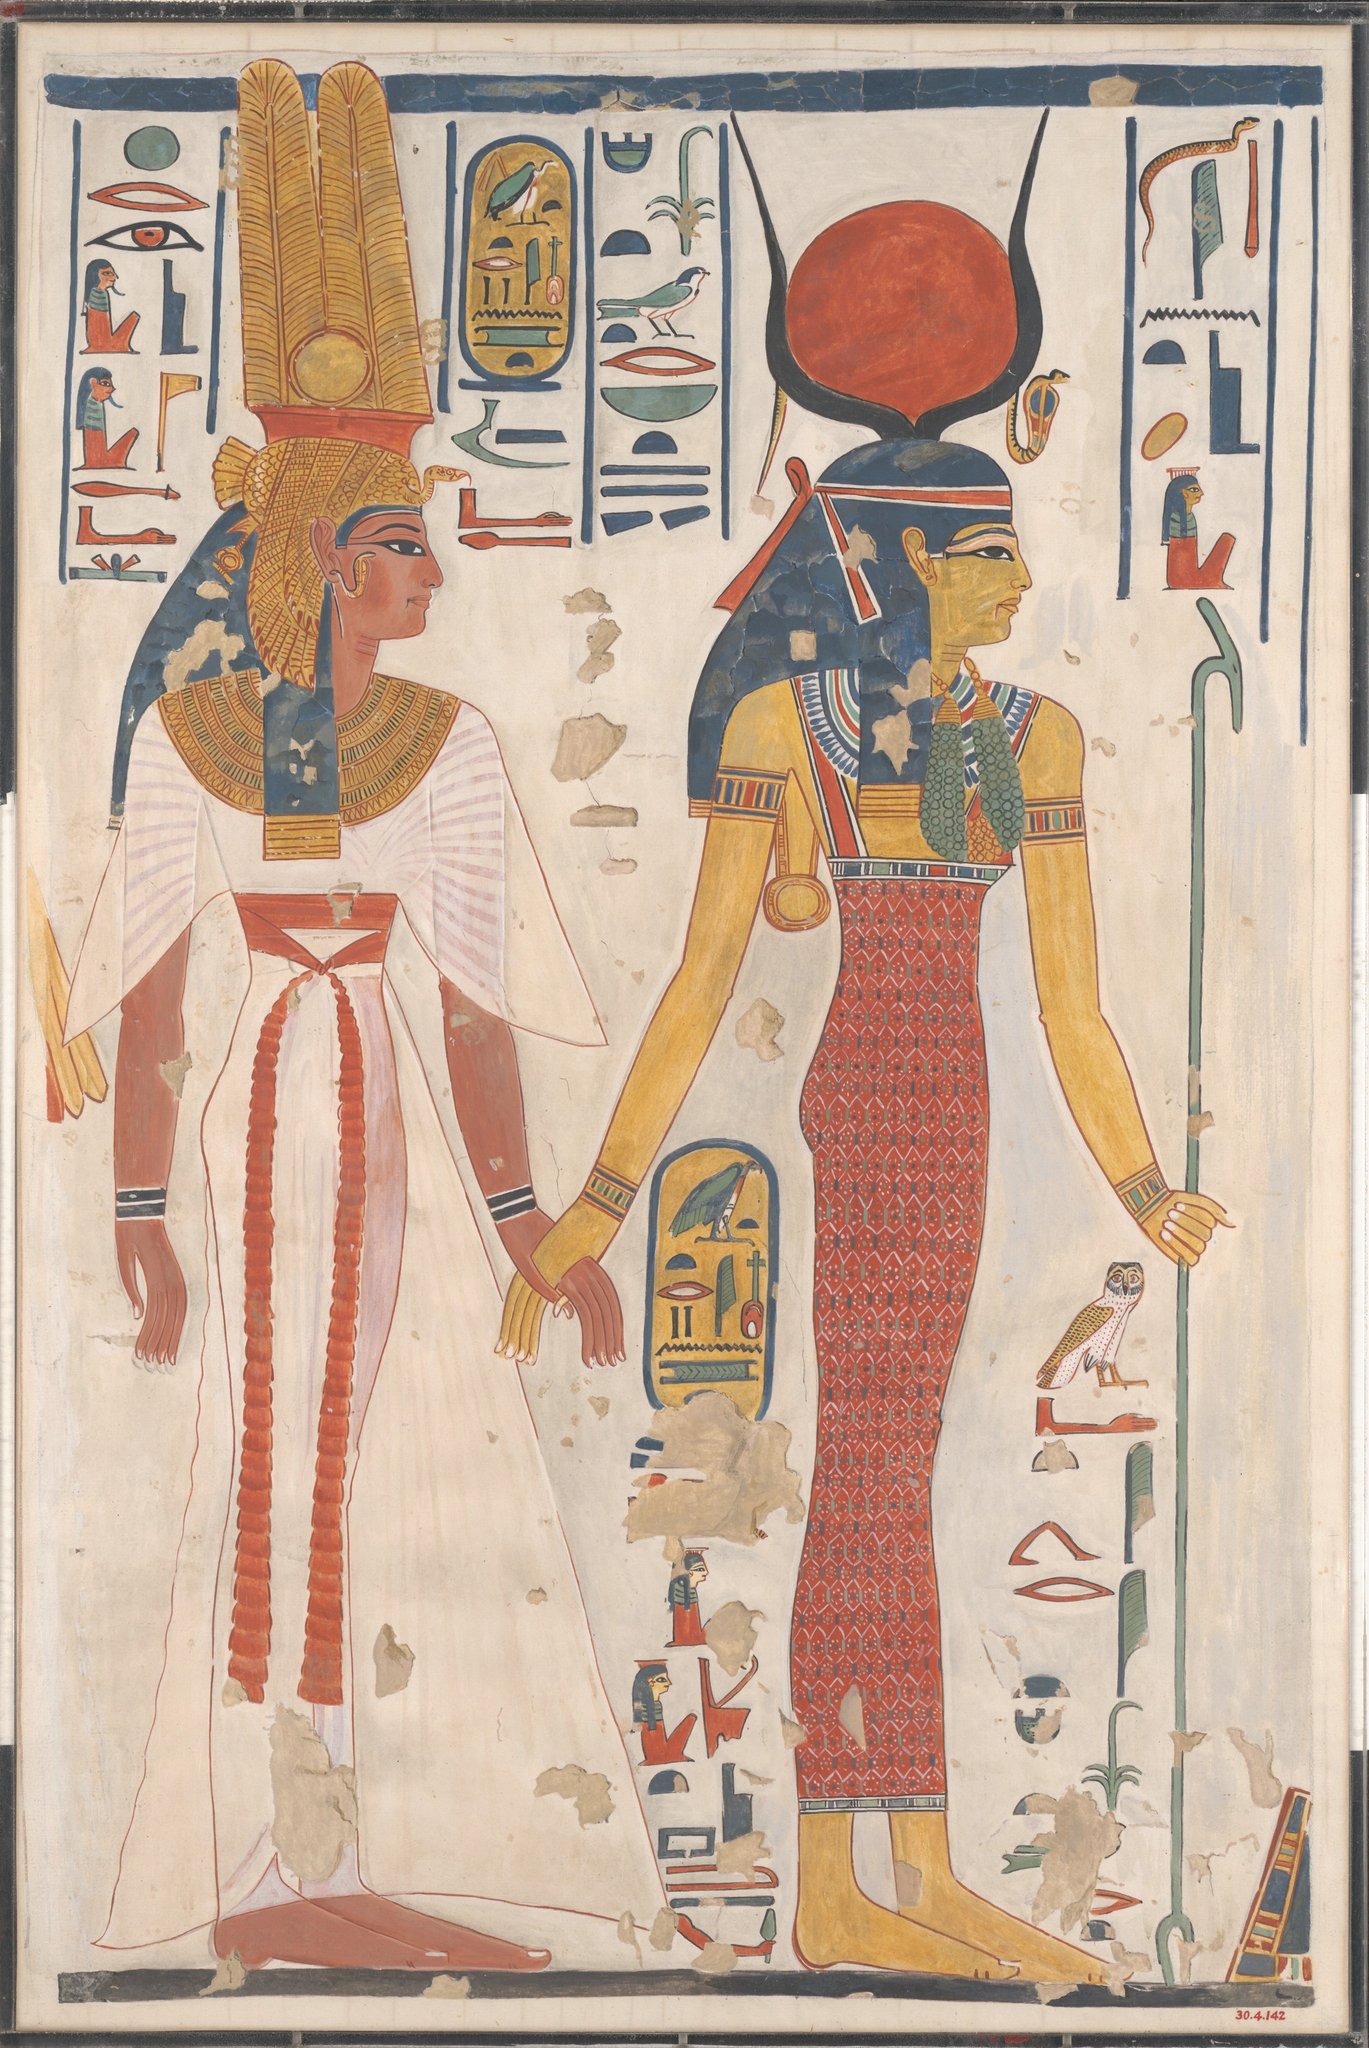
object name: facsimile of a painting in the tomb of nefertari qv 66 nefertari led by isi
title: Queen Nefertari being led by Isis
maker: charles k. wilkinson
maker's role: artist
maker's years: 1897-1986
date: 1279-1213 BCE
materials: paper, paint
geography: egypt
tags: queens,hieroglyphs,isis